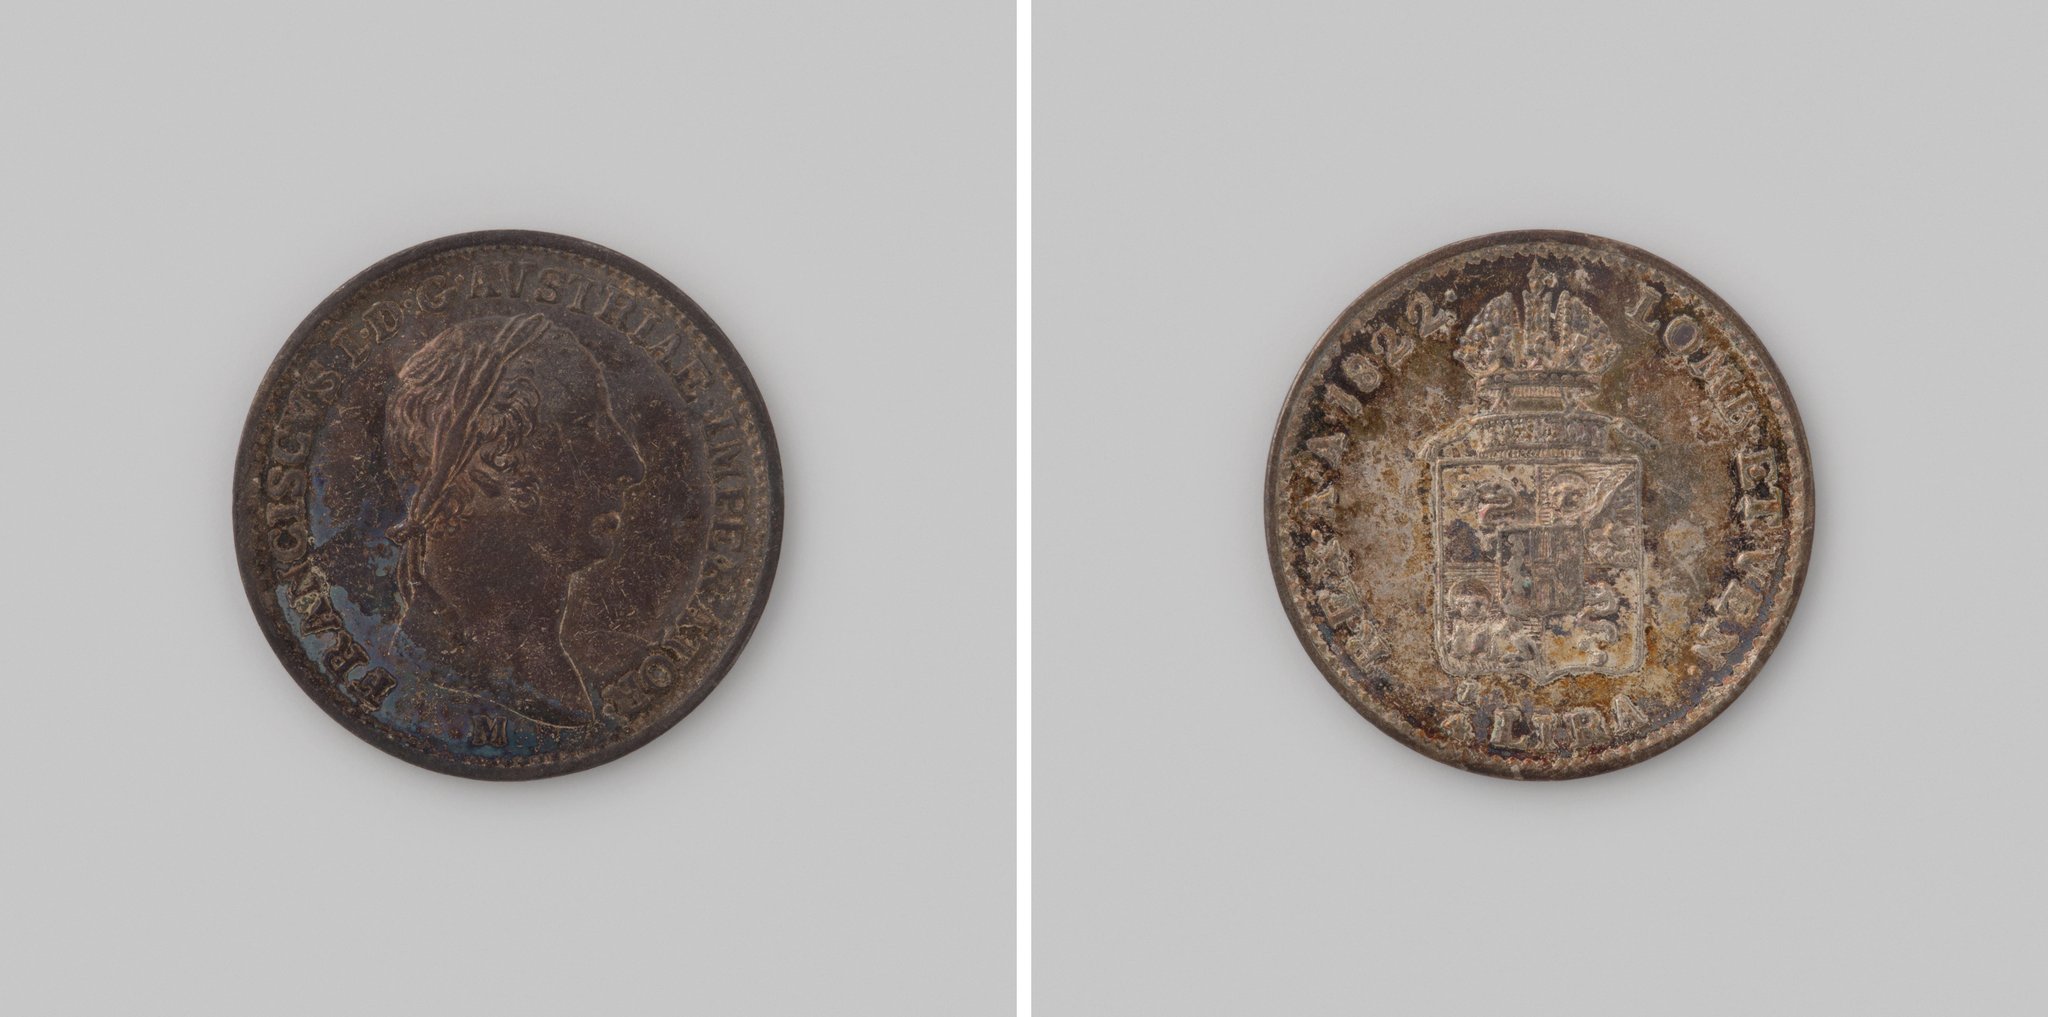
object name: coin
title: Lombardije-Venetië, keizer Franz I van Oostenrijk, 1/4 Oostenrijkse lira, 1822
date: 1822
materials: silver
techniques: striking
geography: milan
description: Zilveren munt. Voorzijde: gelauwerd borstbeeld van de keizer naar rechts. Daaronder letter M [=Milaan]. Keerzijde: gekroond samengesteld wapenschild, waarboven keizerskroon met linten. Waarde-aanduiding onderaan en jaartal aan het eind van het omschrift. Gladde rand.